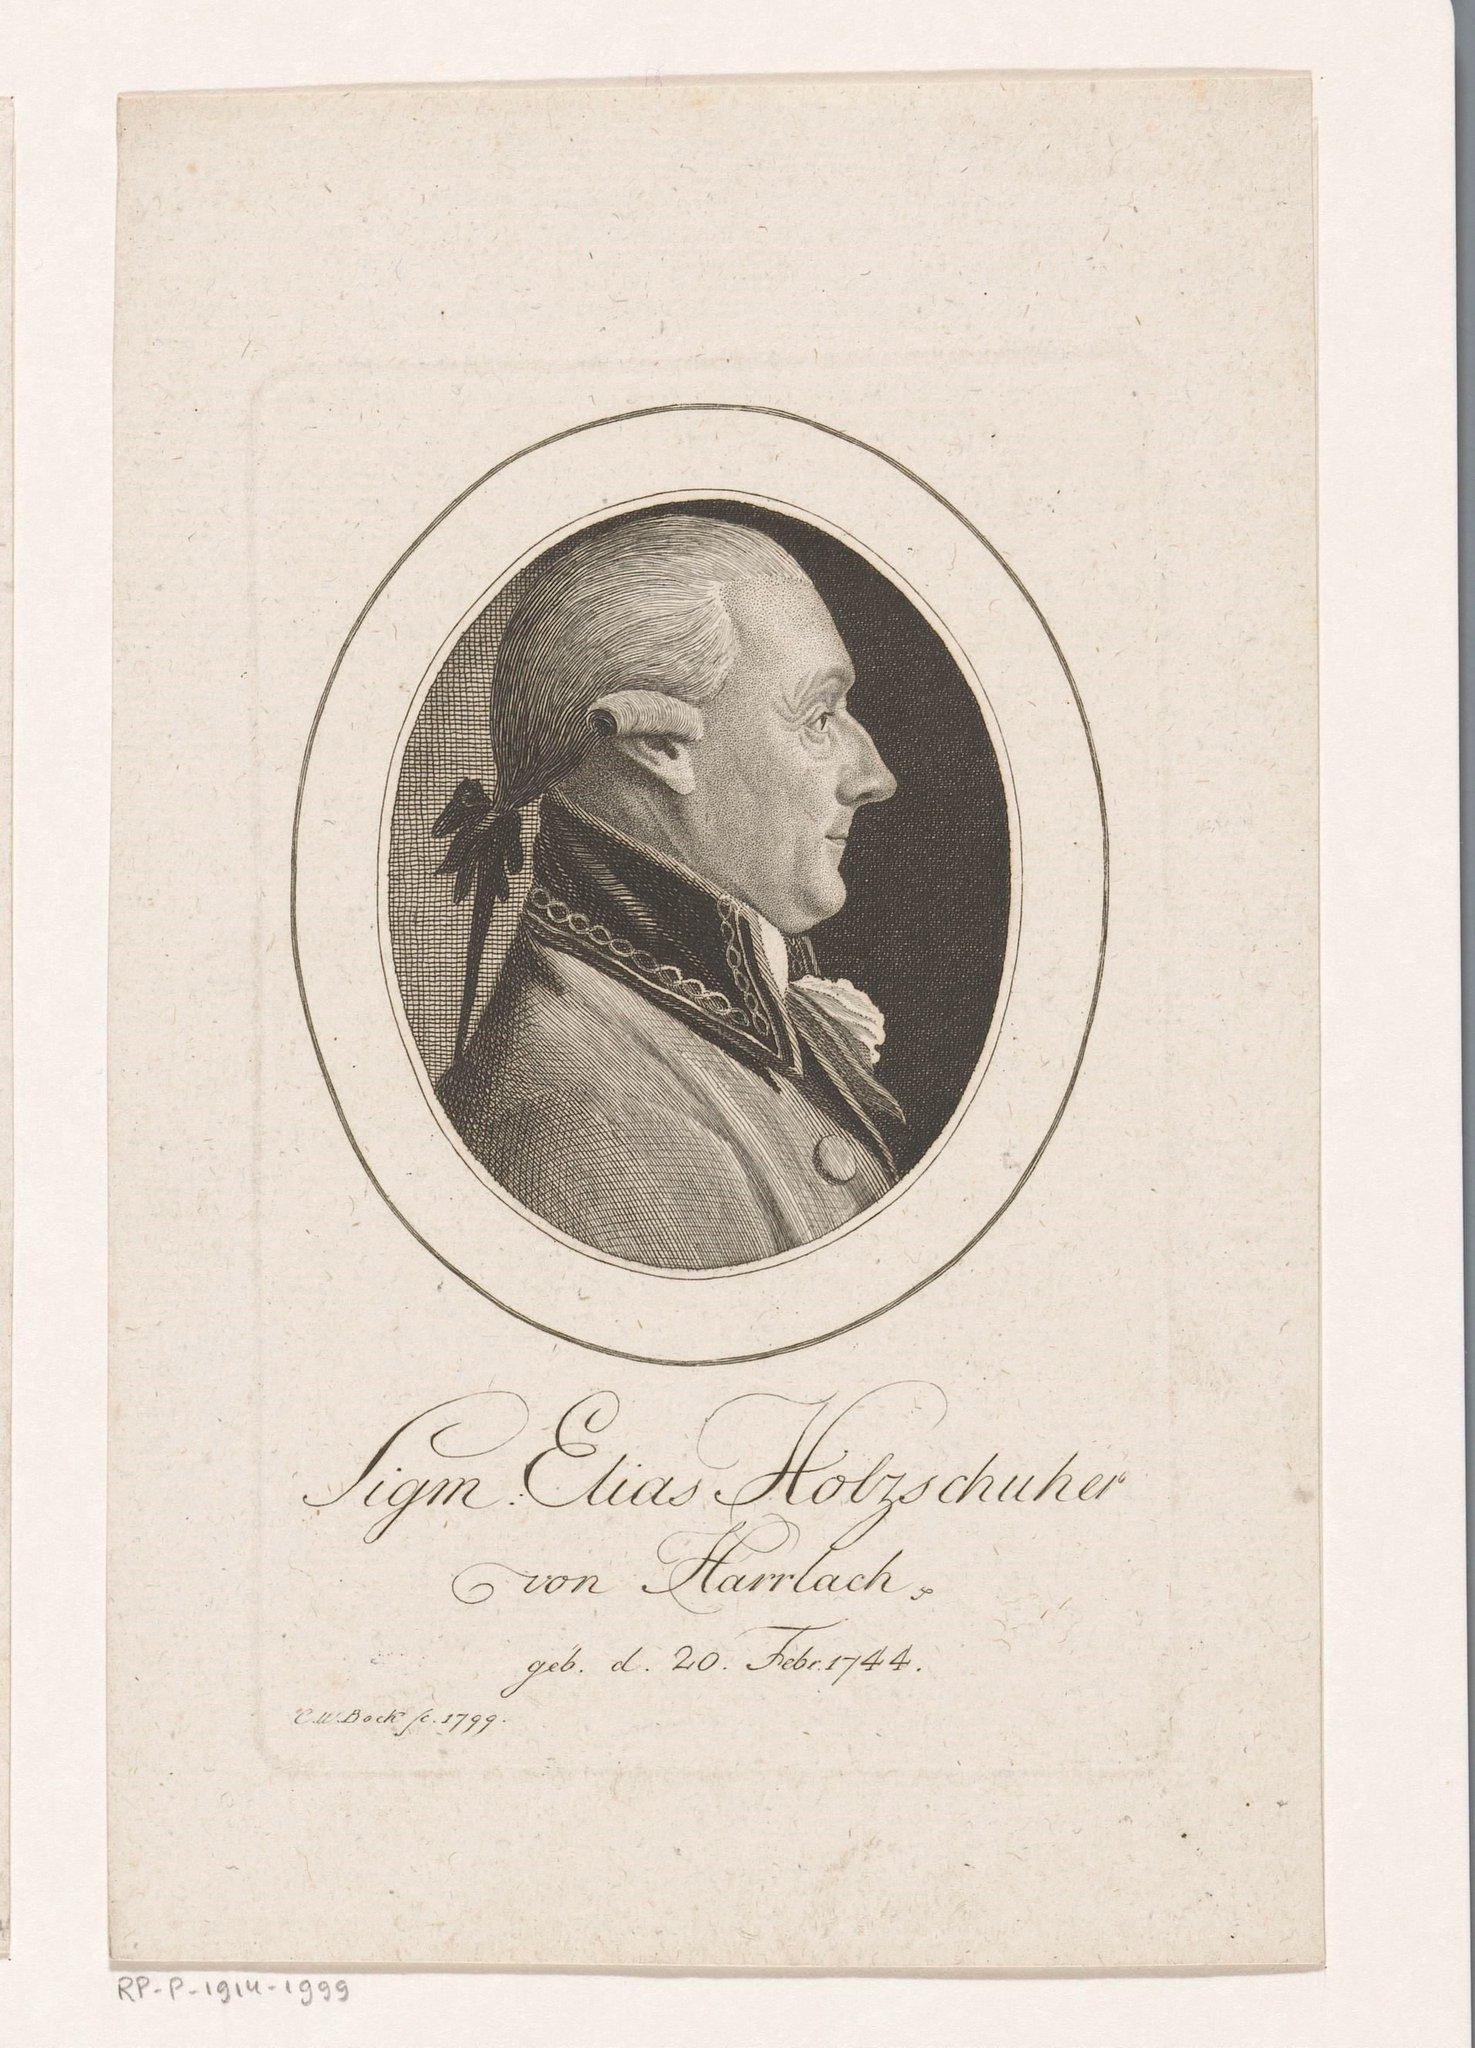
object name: print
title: Portret van Sigismund Elias Holzschuher von Harrlach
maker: christoph wilhelm bock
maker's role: print maker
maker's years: 1755-1836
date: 1799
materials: paper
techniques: engraving, etching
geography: nuremberg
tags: historical persons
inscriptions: collector's mark: Lugt 2228